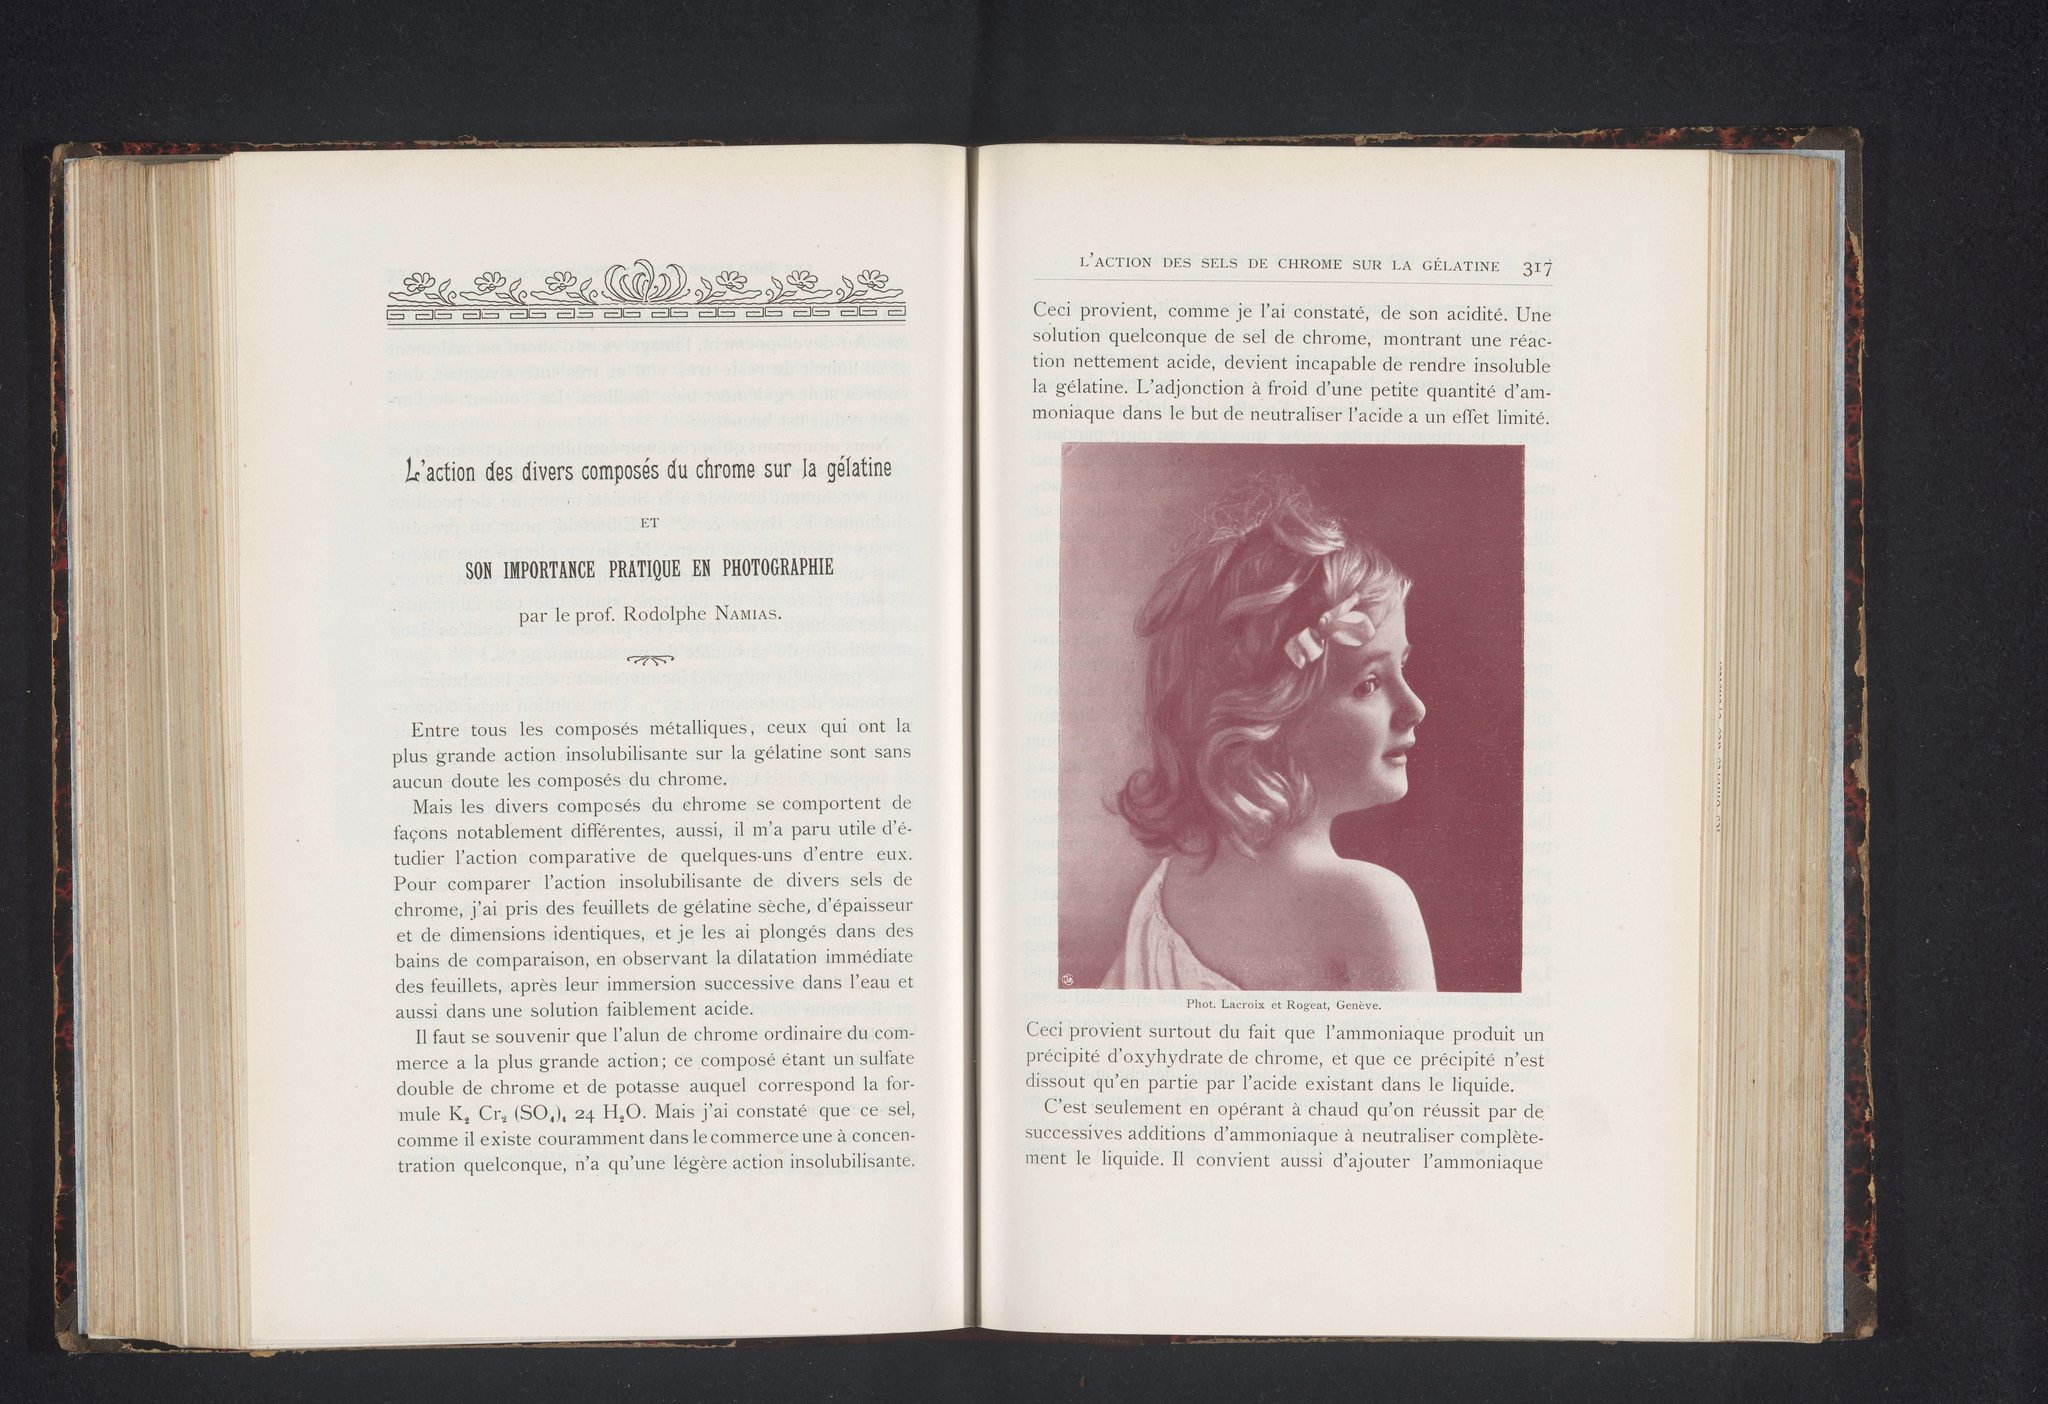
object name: photomechanical print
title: Portret van een onbekend meisje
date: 1897-1902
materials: paper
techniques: autotype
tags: historical persons - bb - woman, girl (child between toddler and youth)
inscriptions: monogram: ‘C. Cie’